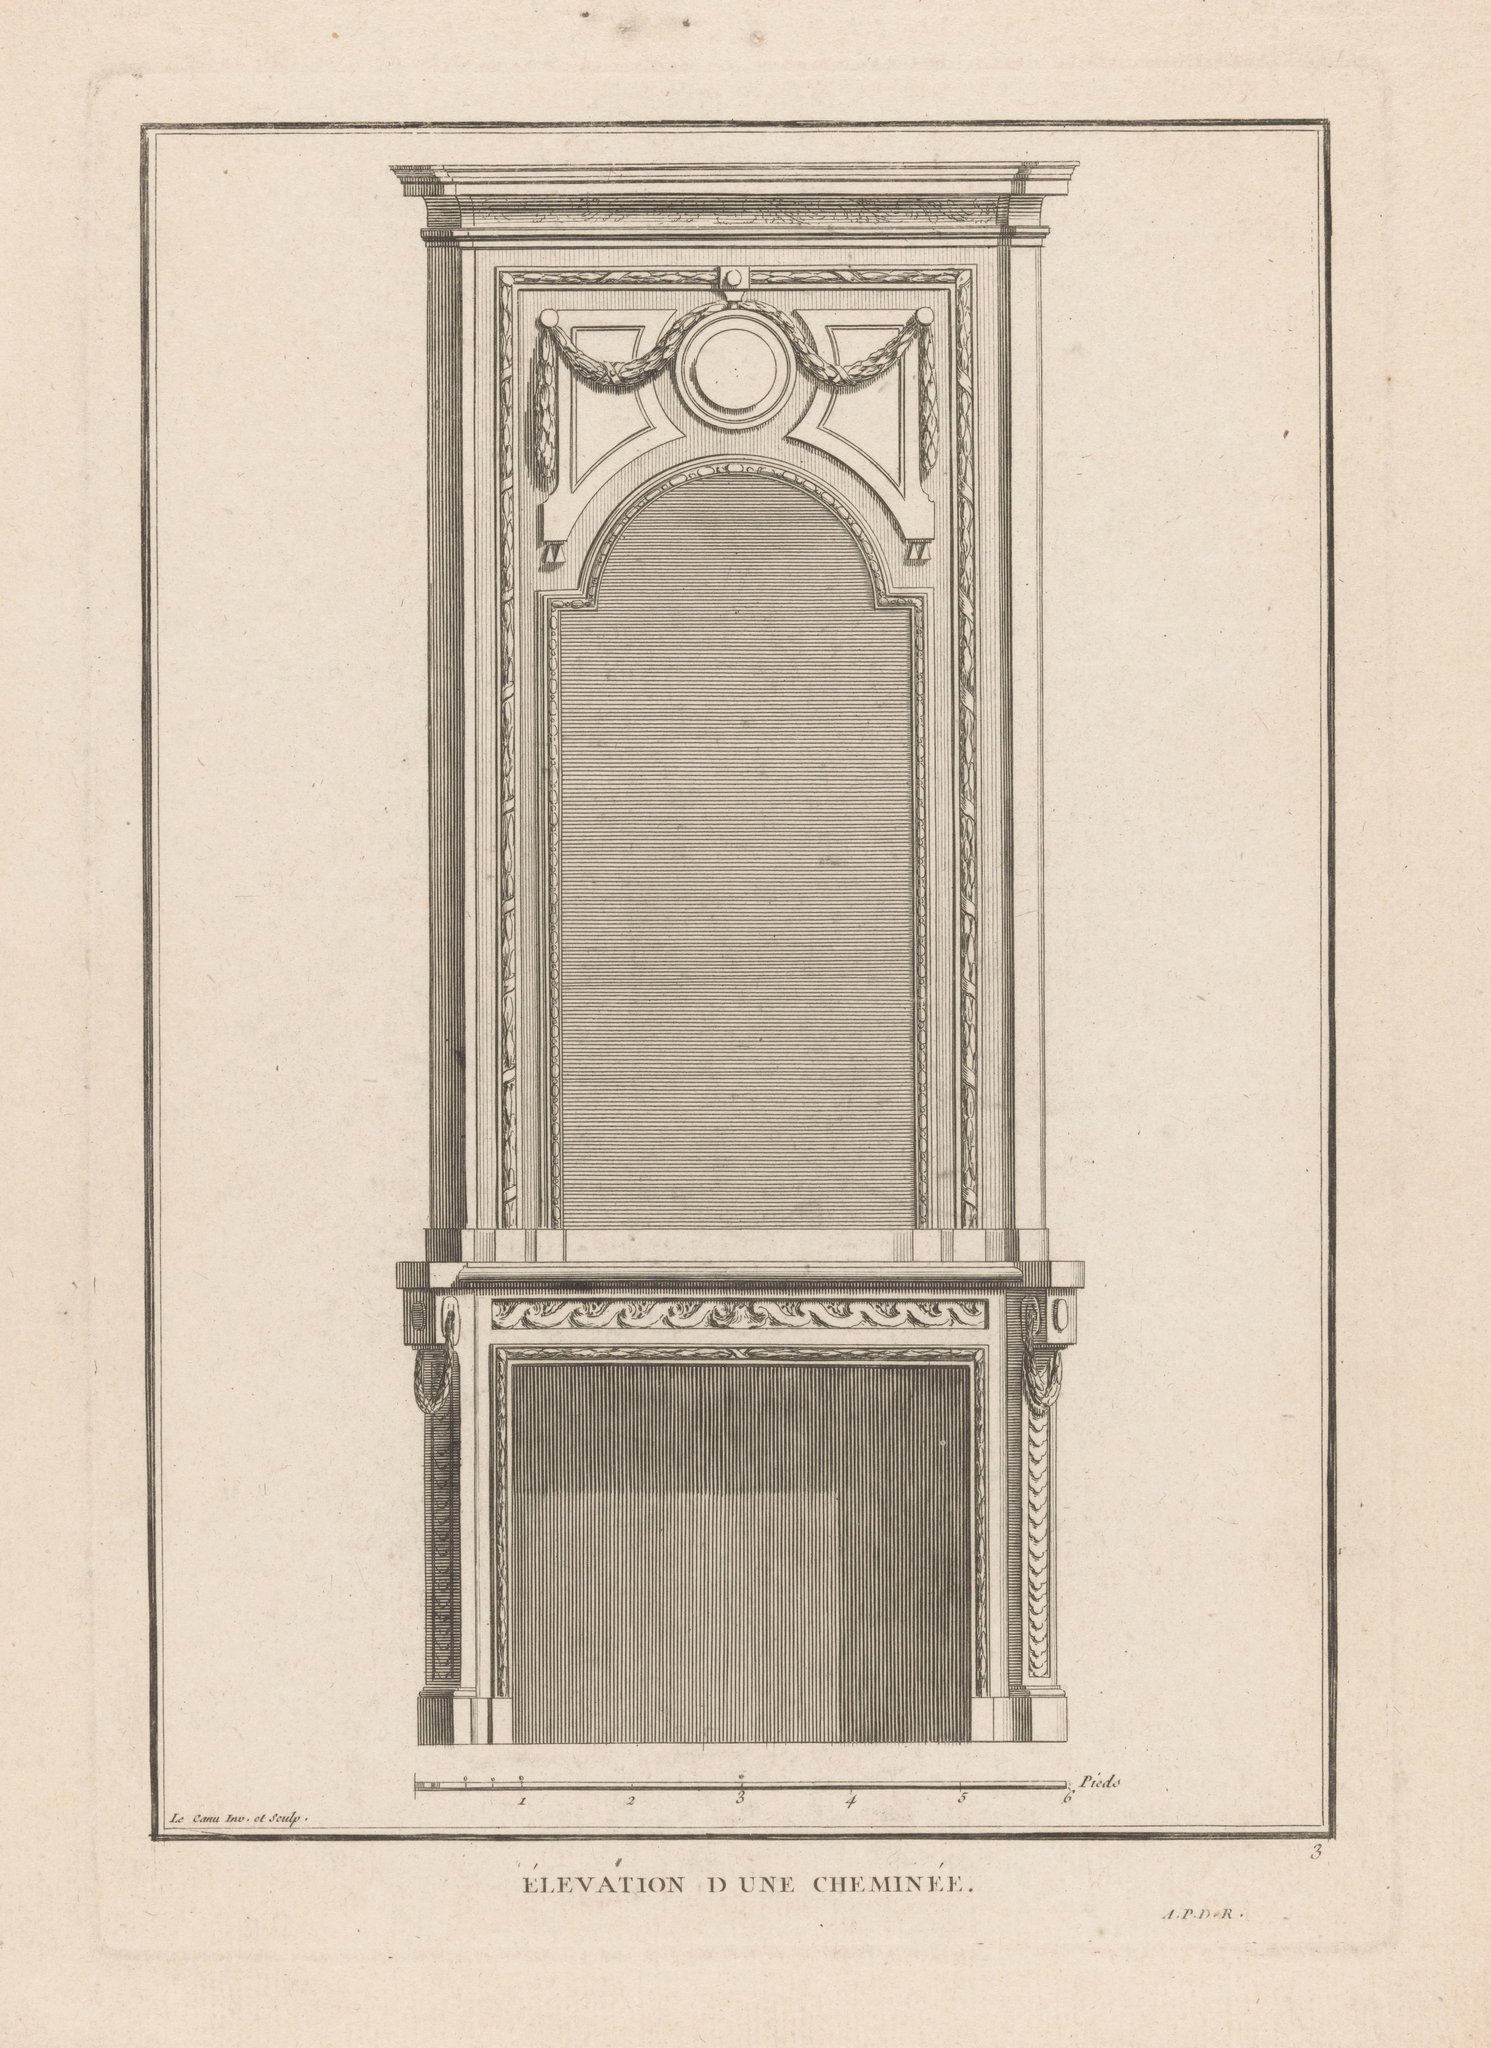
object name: titelprent, frontispice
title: Élevation D Une Cheminée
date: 1778-1782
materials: paper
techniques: etching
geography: paris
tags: open hearth, fire-place, ornament ~ festoon, garland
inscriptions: collector's mark: Lugt 2228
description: Een geornamenteerde haard met guirlandes en een rond element aan de bovenzijde.